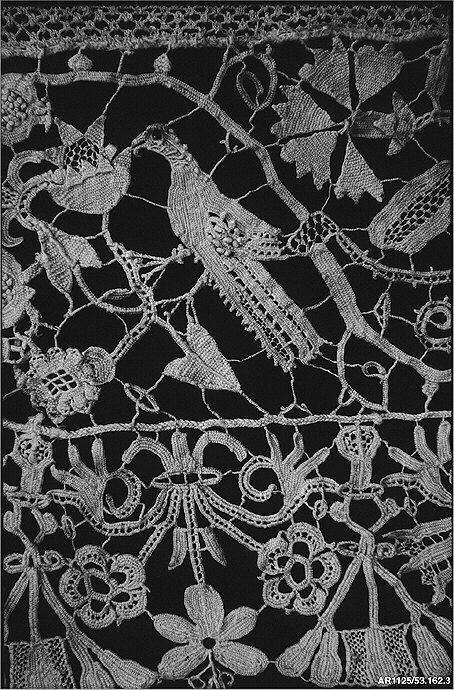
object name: piece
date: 1601-1633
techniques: lace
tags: birds,flowers